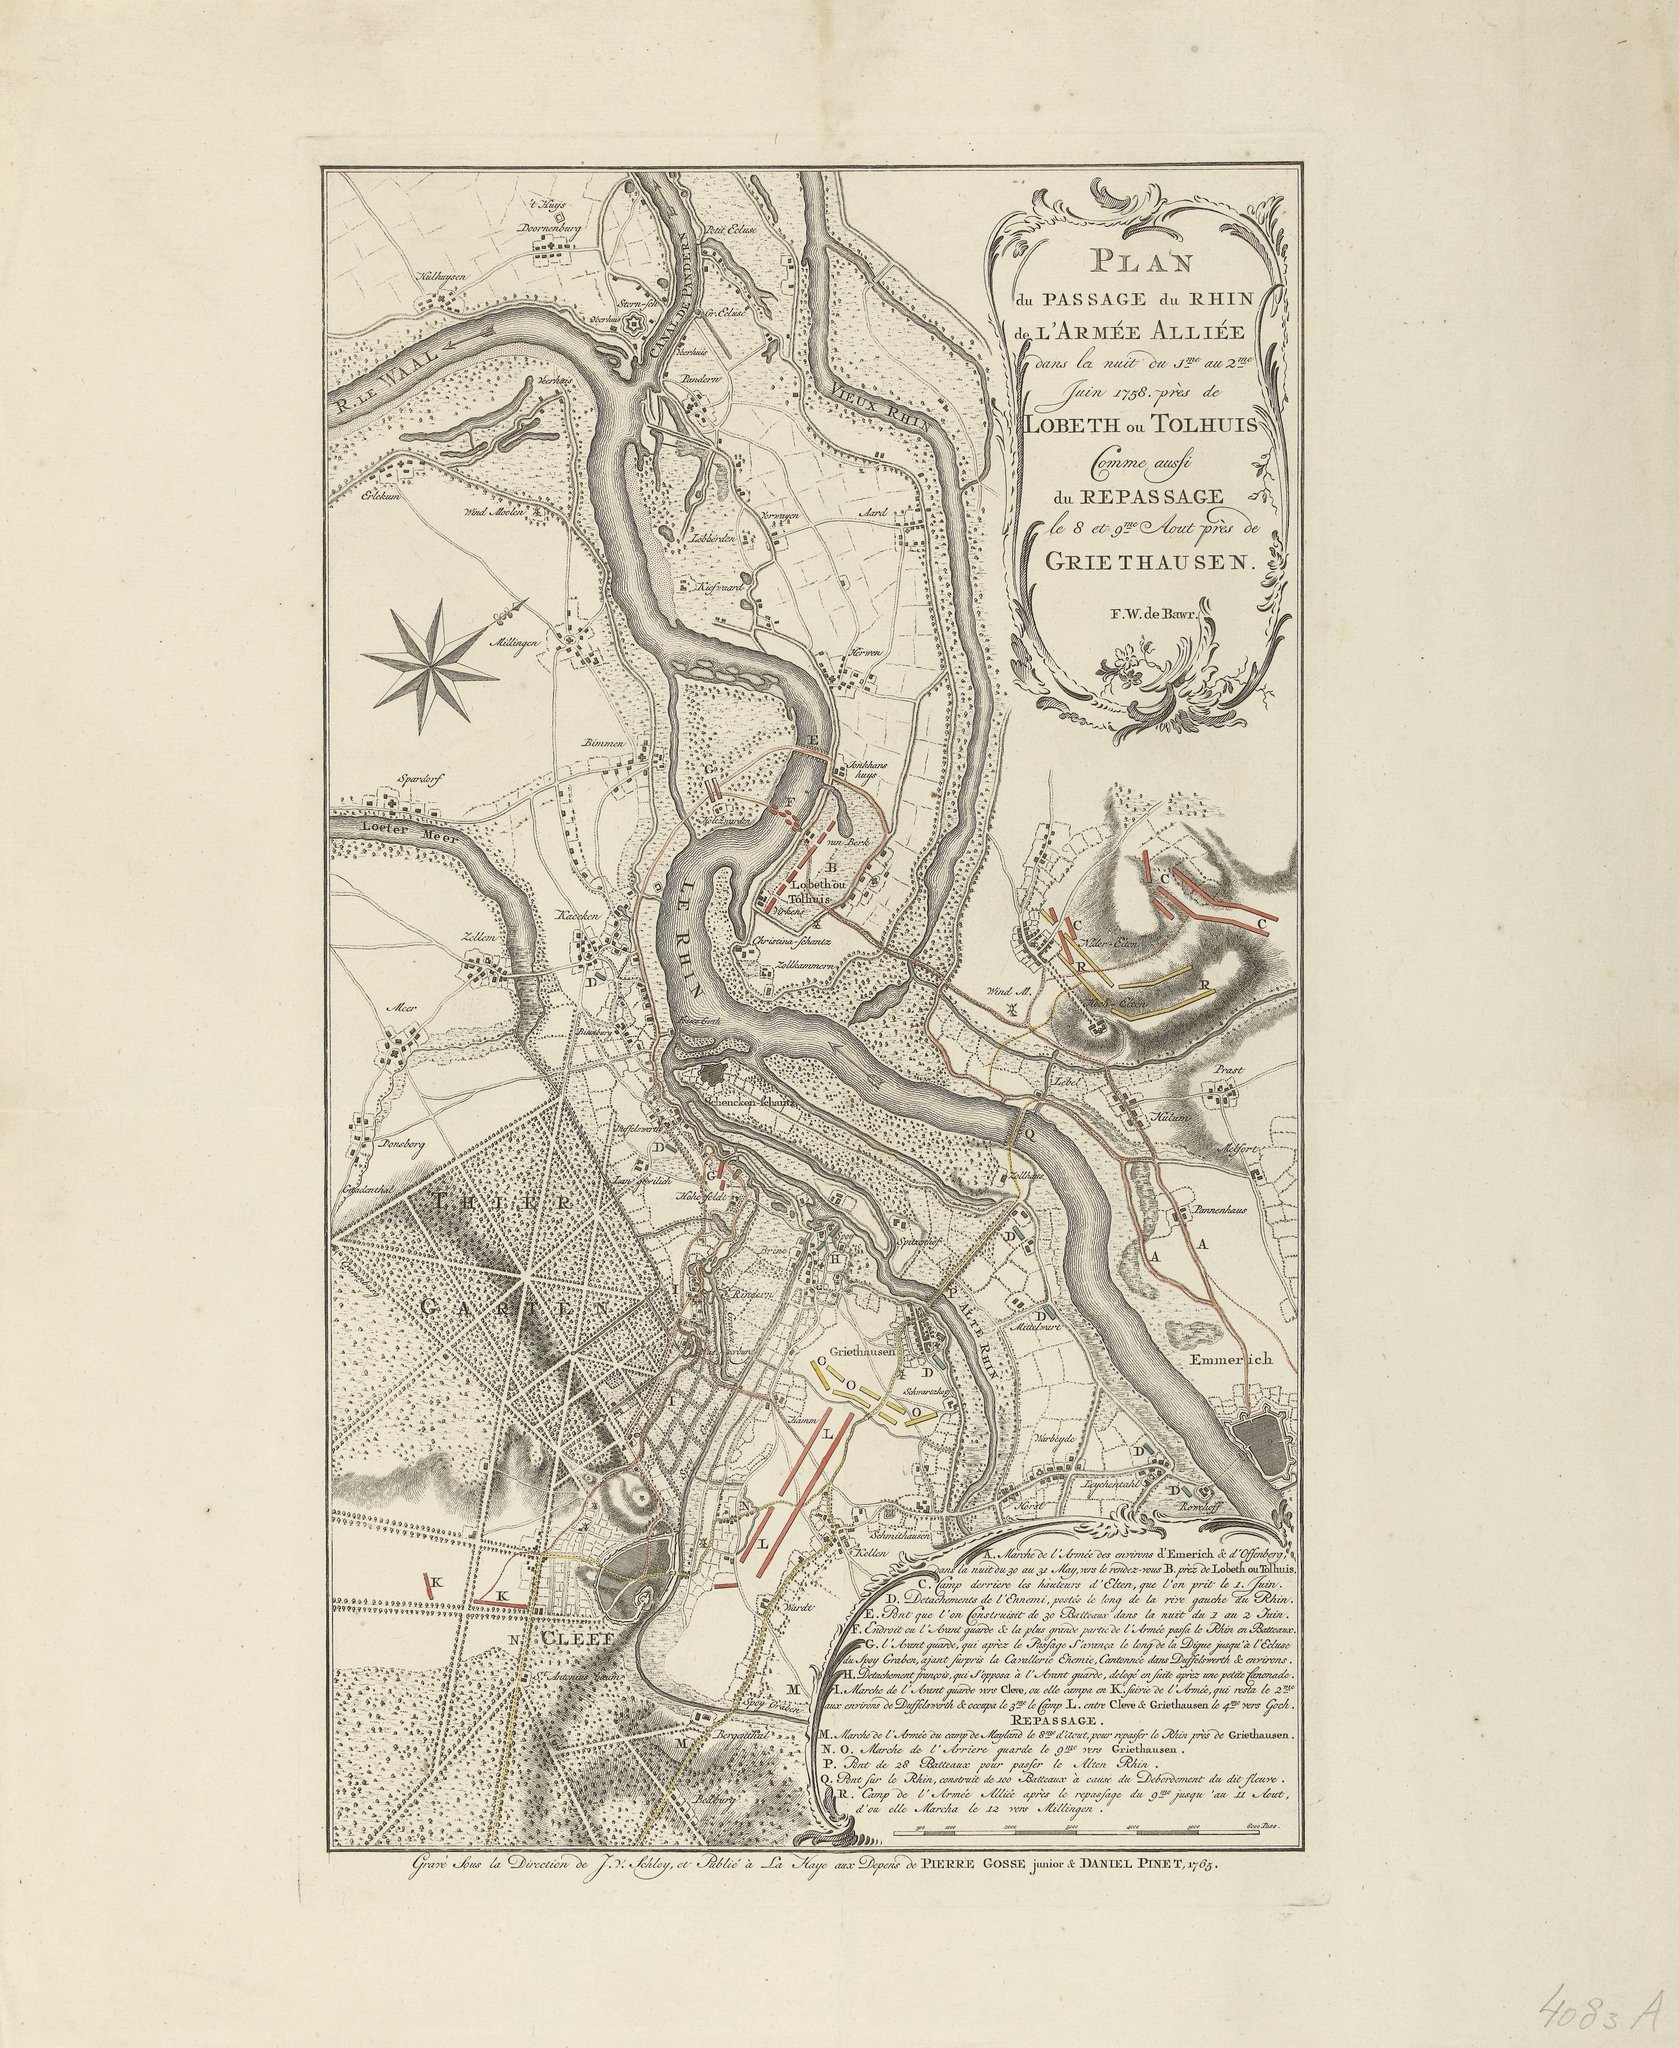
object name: history print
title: Kaart van de oversteek van het geallieerde leger bij Lobith, 1758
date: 1765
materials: paper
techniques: etching, hand coloring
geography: the hague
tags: maps of separate countries or regions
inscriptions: collector's mark: Lugt 2228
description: Kaart van de loop van de rivier de Rijn tussen Emmerich en Panderen waarop is aangegeven waar het geallieerde leger in de nacht van 1 op 2 juni 1758 de rivier bij Lobith of Tolhuis is overgestoken en in de nacht van 8 op 9 augustus bij Griethausen weer is teruggekeerd. Rechtsonder een cartouche met de legenda A-R in het Frans. Onder de titel de naam: F.W. de Bawr.